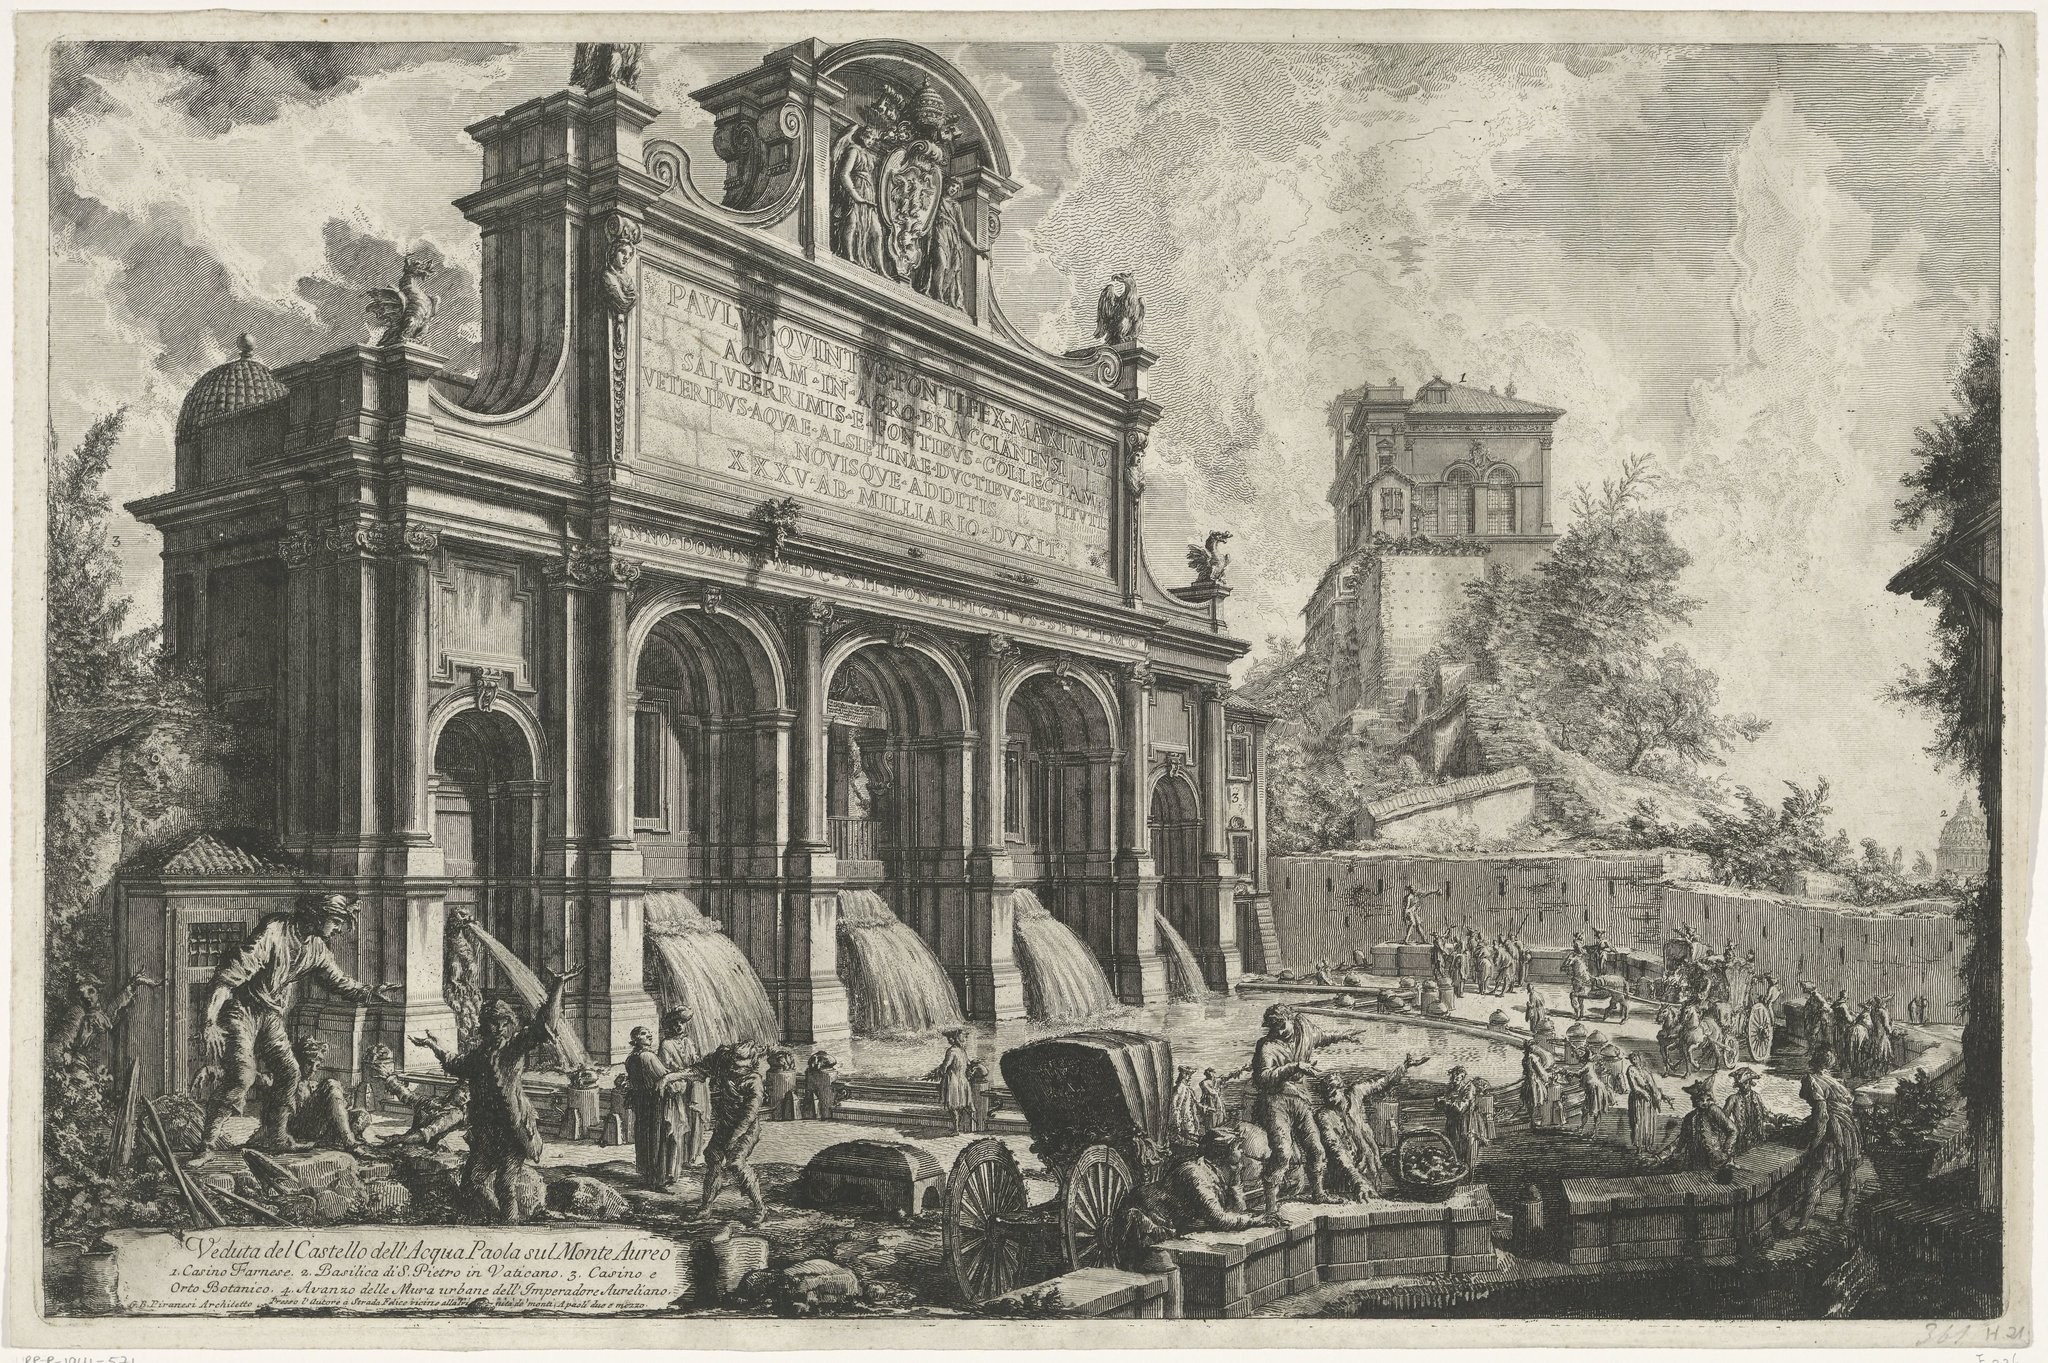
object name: print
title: Veduta del Castello dell'Acqua Paola sul Monte Aureo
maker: giovanni battista piranesi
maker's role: designer, draughtsman, print maker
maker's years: 1720-1778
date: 1748-1778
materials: paper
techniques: etching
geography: rome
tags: ornamental fountain, rome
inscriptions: collector's mark: Lugt 2228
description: Deze prent maakt deel uit van de serie 'Vedute di Roma'. Piranesi werkte aan deze 135 platen tellende serie tussen 1748 en zijn dood in 1778. Francesco Piranesi voegde later nog twee prenten toe aan de reeks van zijn vader.